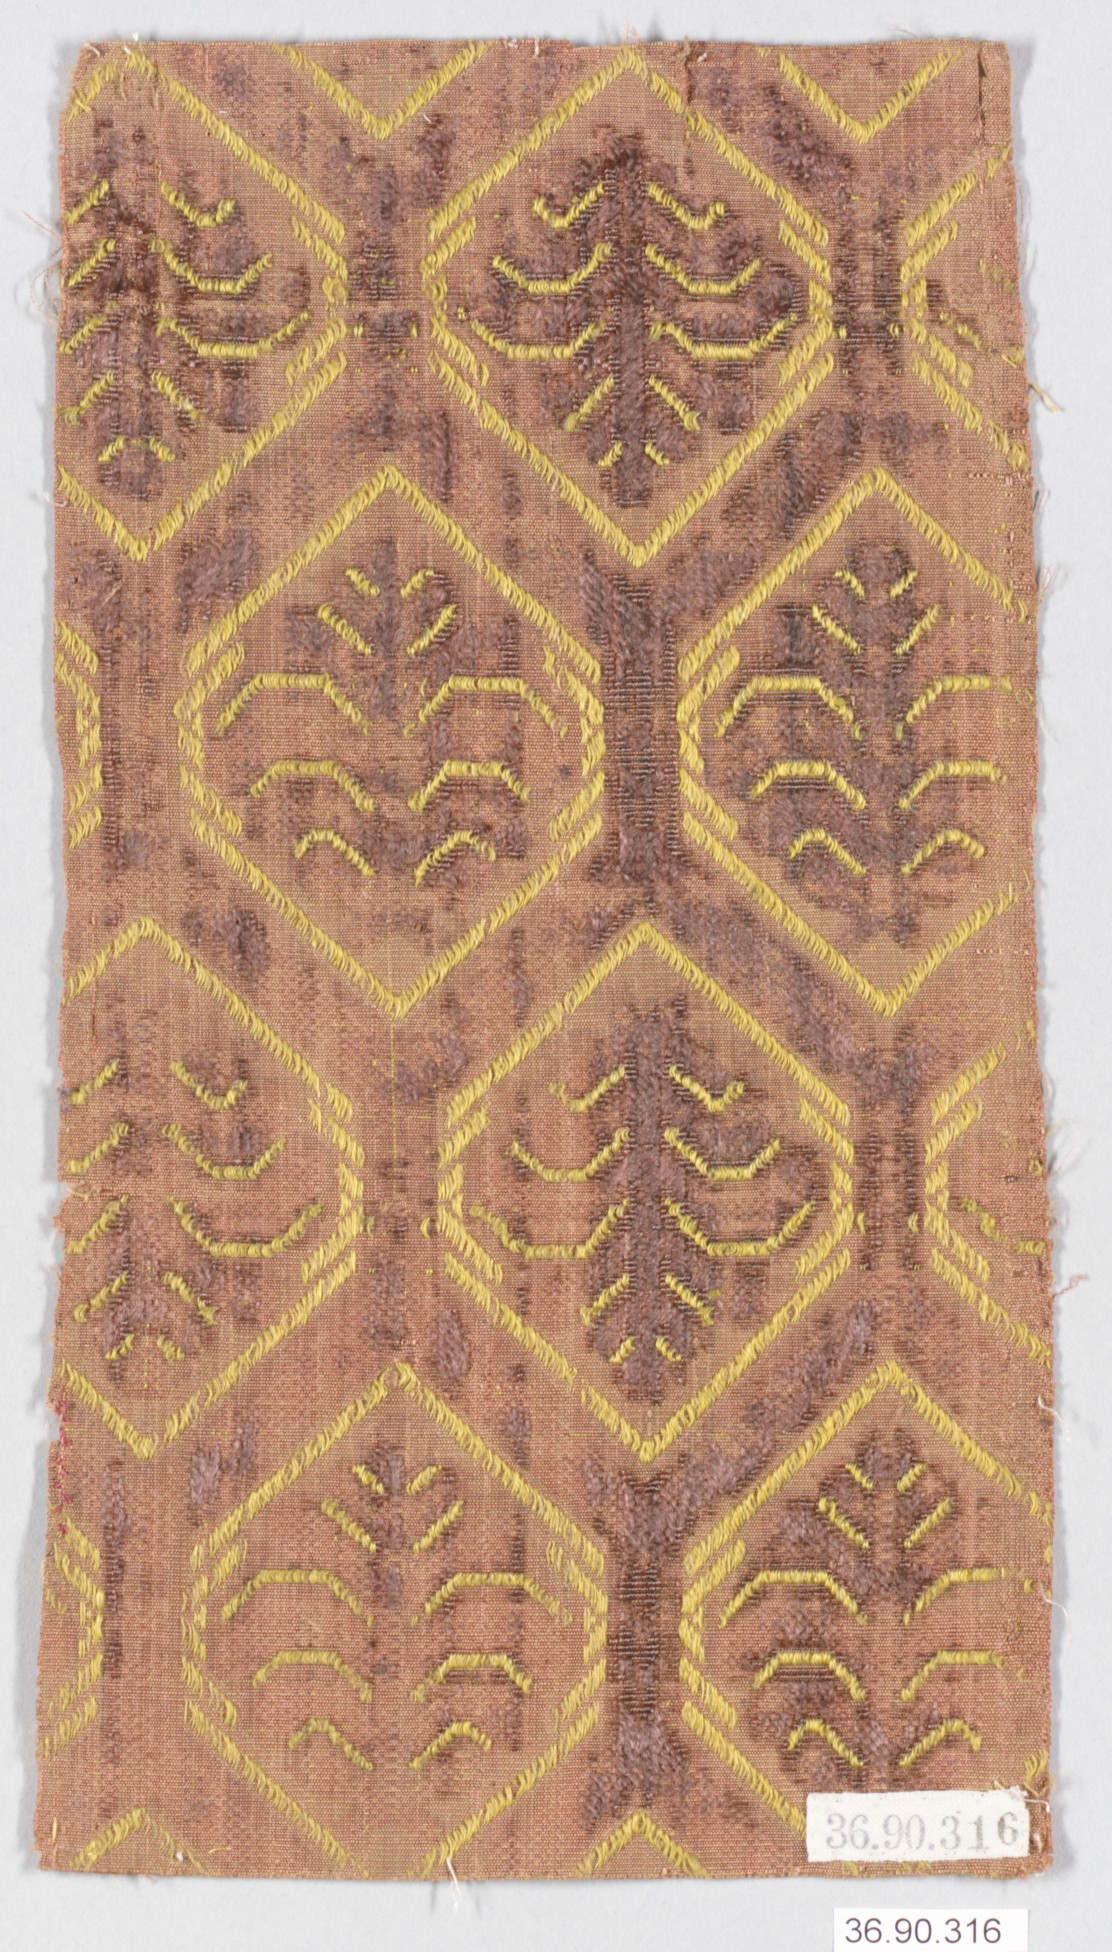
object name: piece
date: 1501-1700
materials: silk